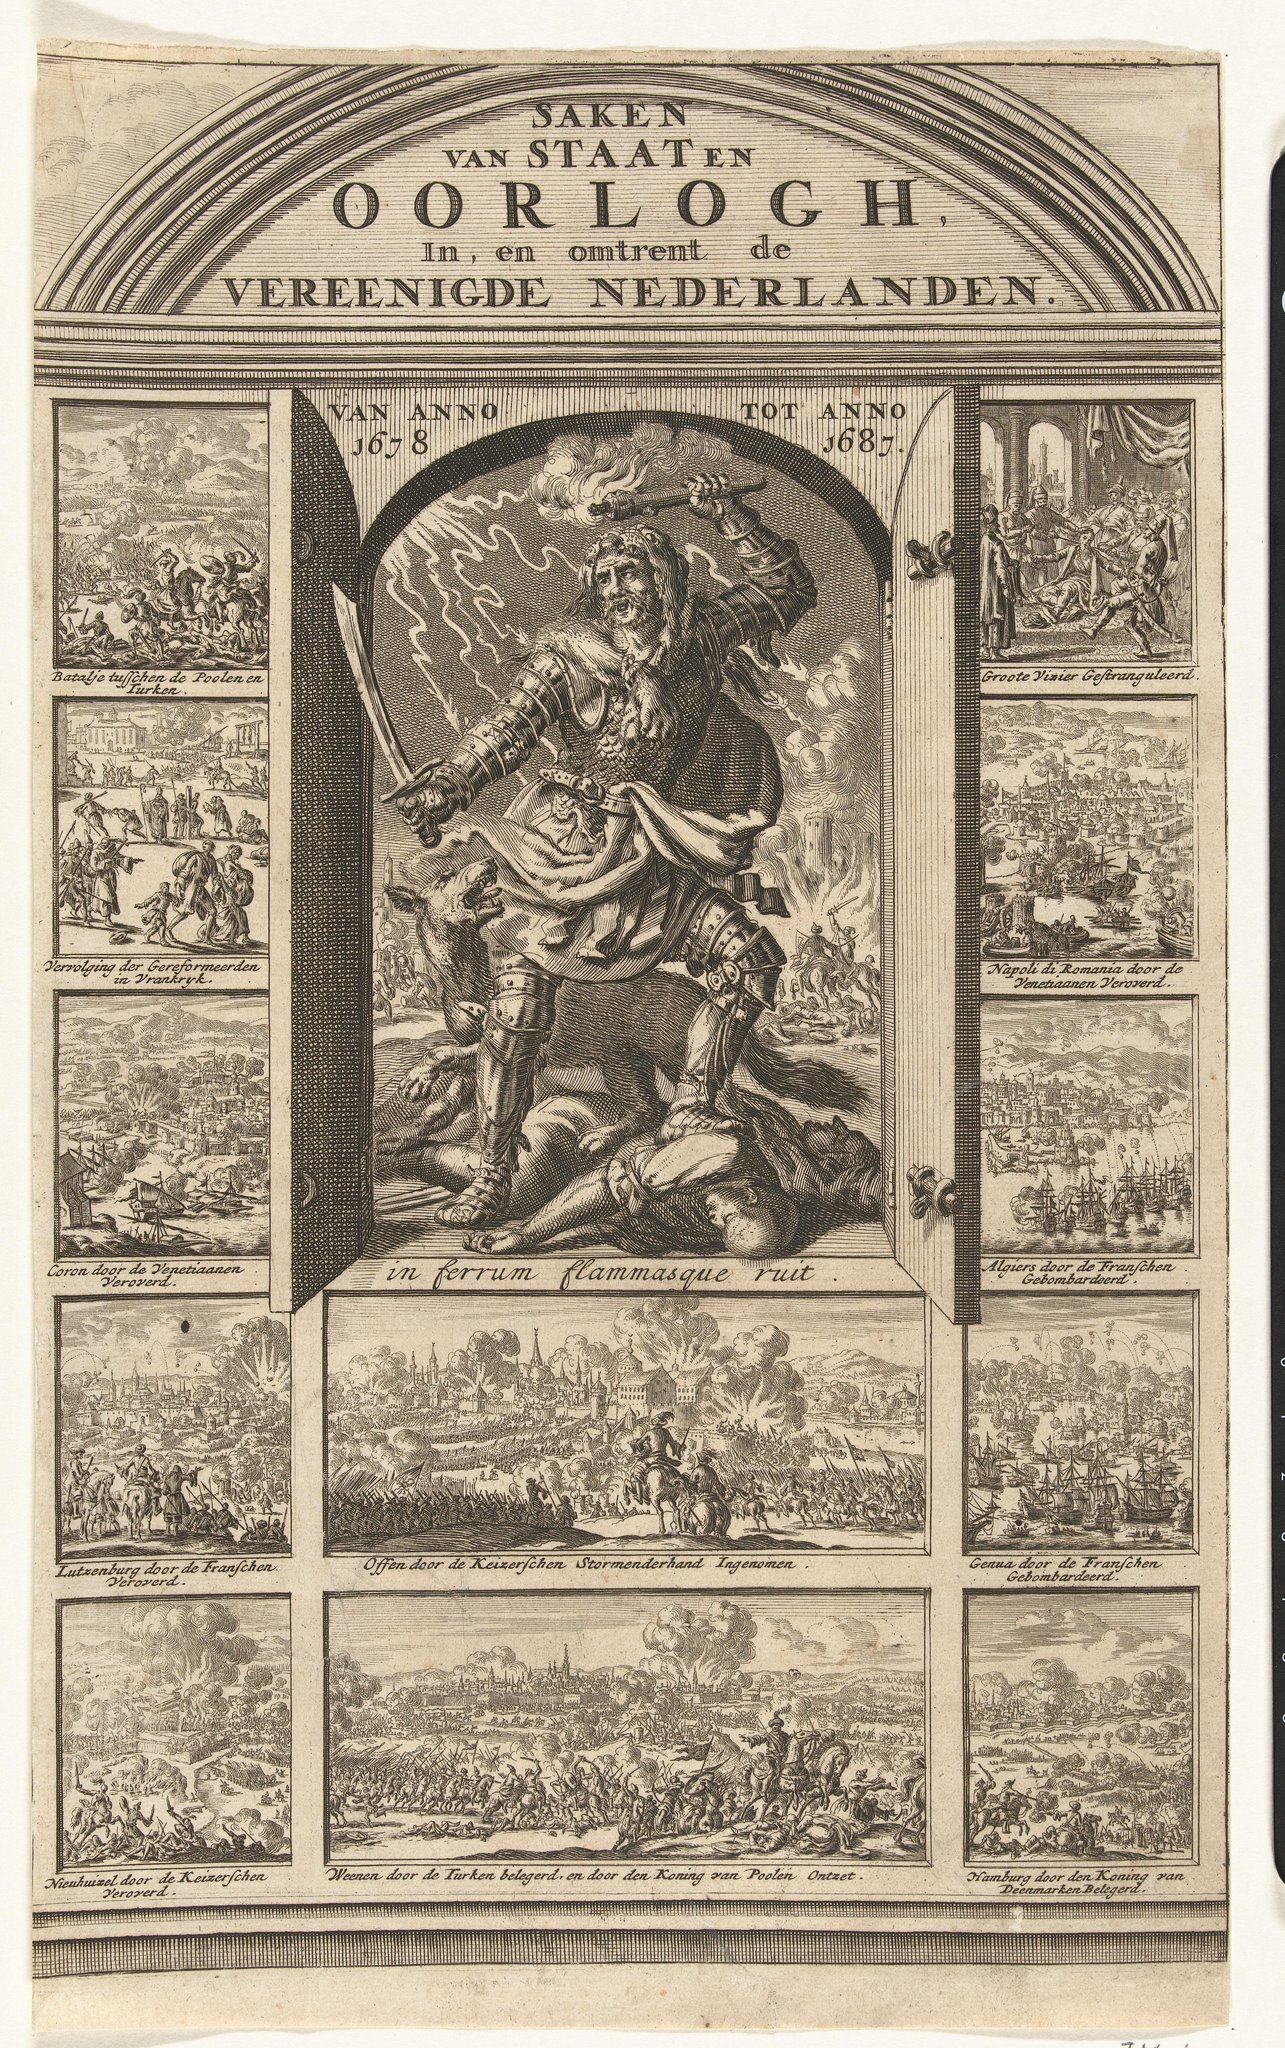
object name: print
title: Saken van Staat en Oorlogh, In en omtrent de Vereenigde Nederlanden. van Anno 1678 tot anno 1687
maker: jan luyken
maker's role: draughtsman, print maker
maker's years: 1649-1712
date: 1687-1688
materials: paper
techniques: engraving, etching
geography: northern netherlands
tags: symbols, allegories of war; 'guerra' (ripa)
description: Titelpagina voor: L. Sylvius (= Lambert van den Bosch), Historien onses tyds (1688). Openstaande deuren waarachter een woeste krijgsman met fakkel en zwaard. Omringd door 12 kleinere scènes van oorlogshandelingen uit de jaren 1678-1687, met onderschriften.